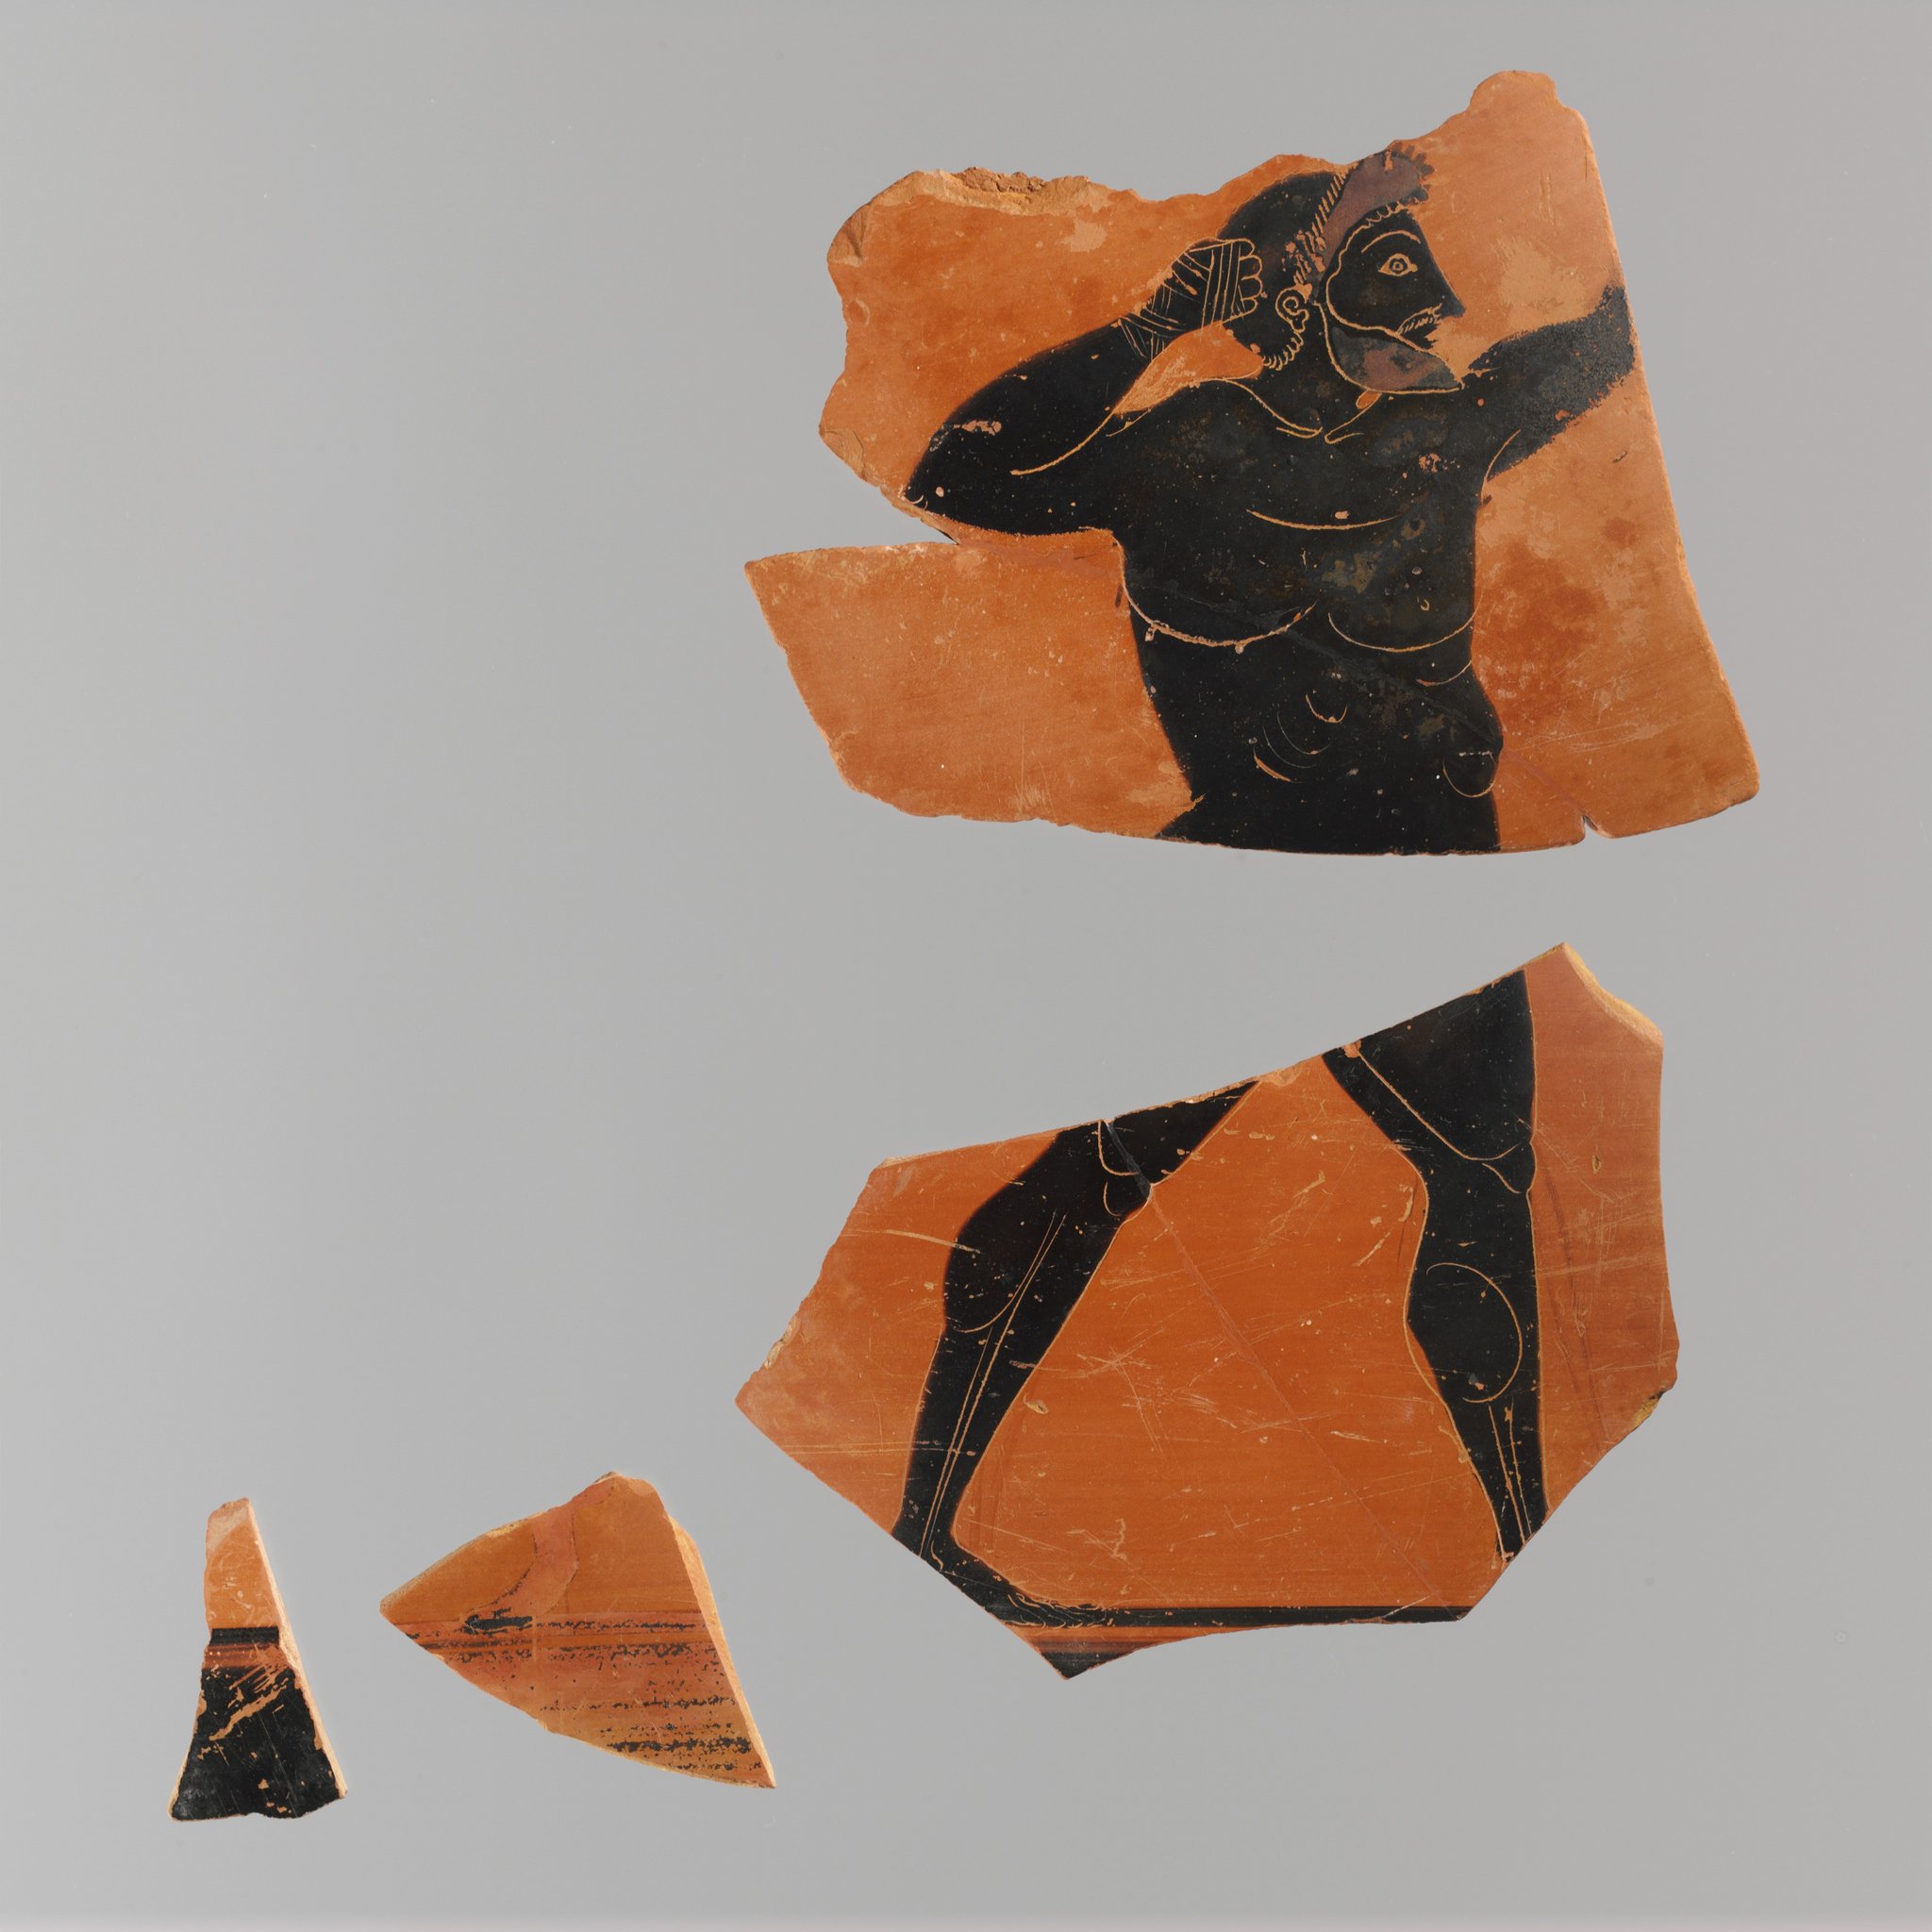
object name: amphora fragment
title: Fragments of a terracotta amphora (jar)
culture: greek, attic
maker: painter of tarquinia rc 6847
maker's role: artist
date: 550-525 BCE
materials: terracotta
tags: men,athletes